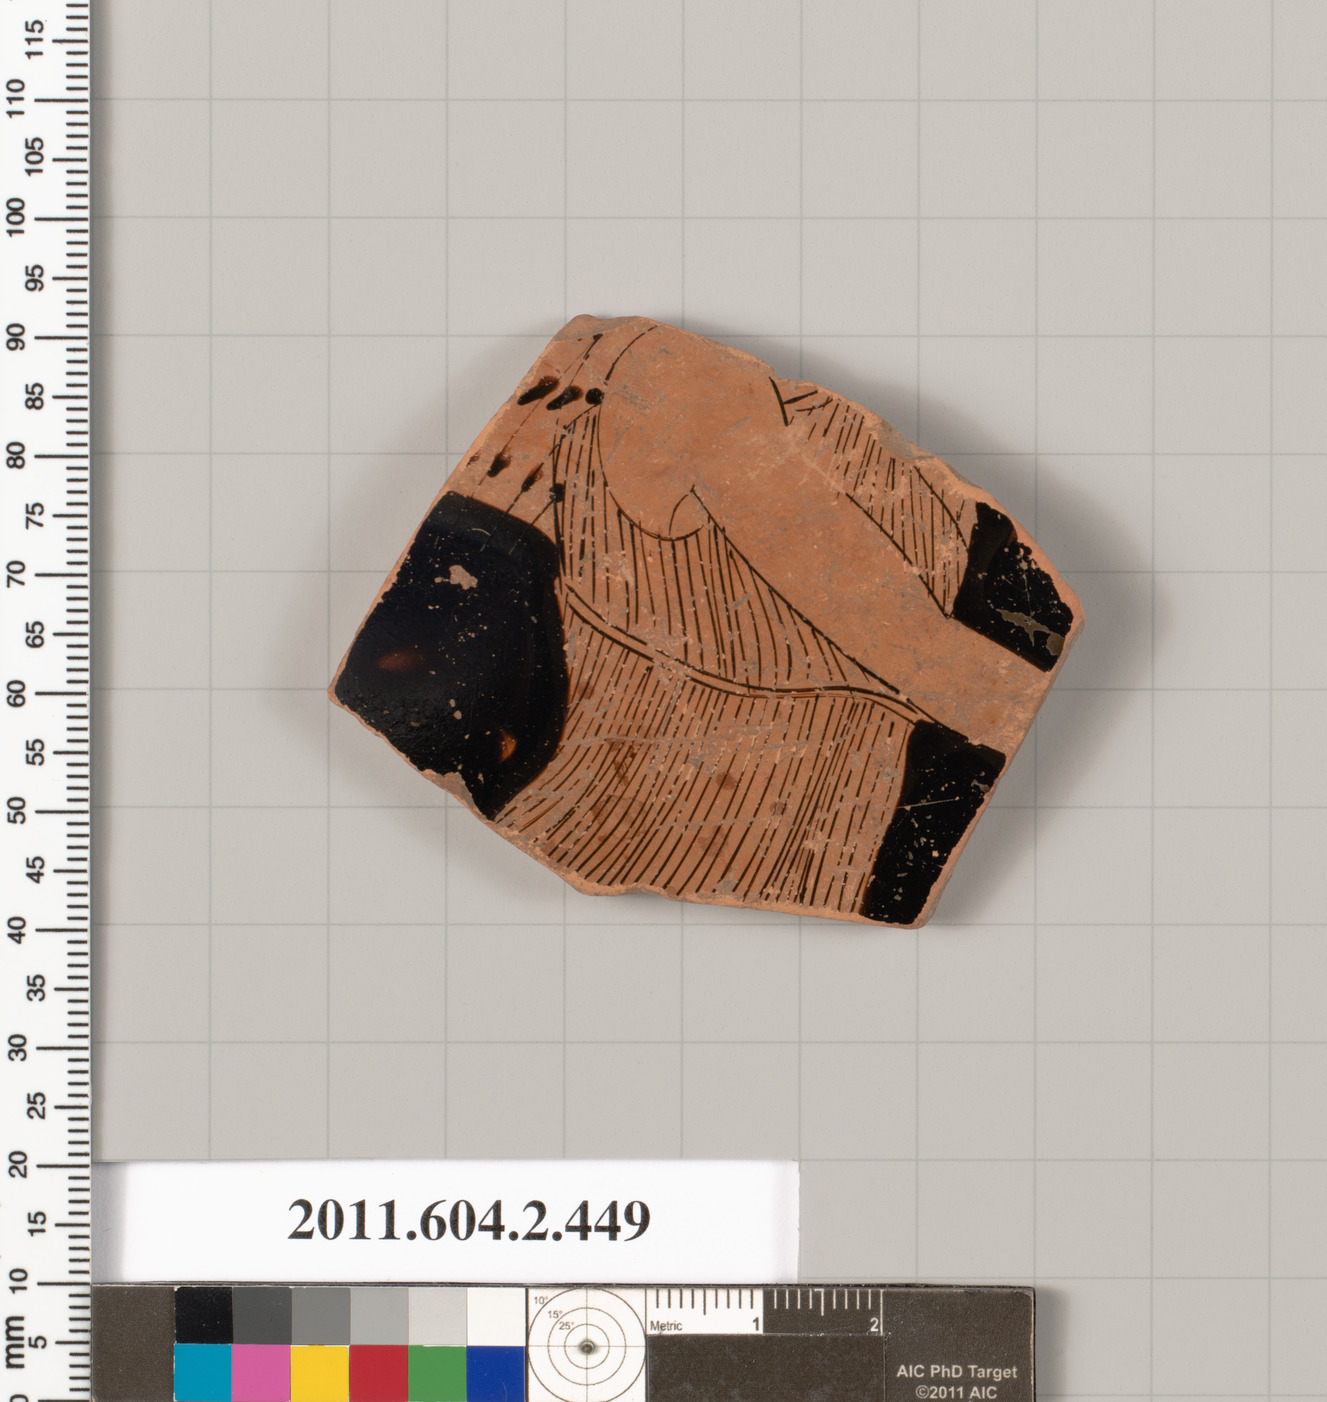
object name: column krater fragment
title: Terracotta fragment of a column-krater (bowl for mixing wine and water)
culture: greek, attic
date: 490-480 BCE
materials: terracotta